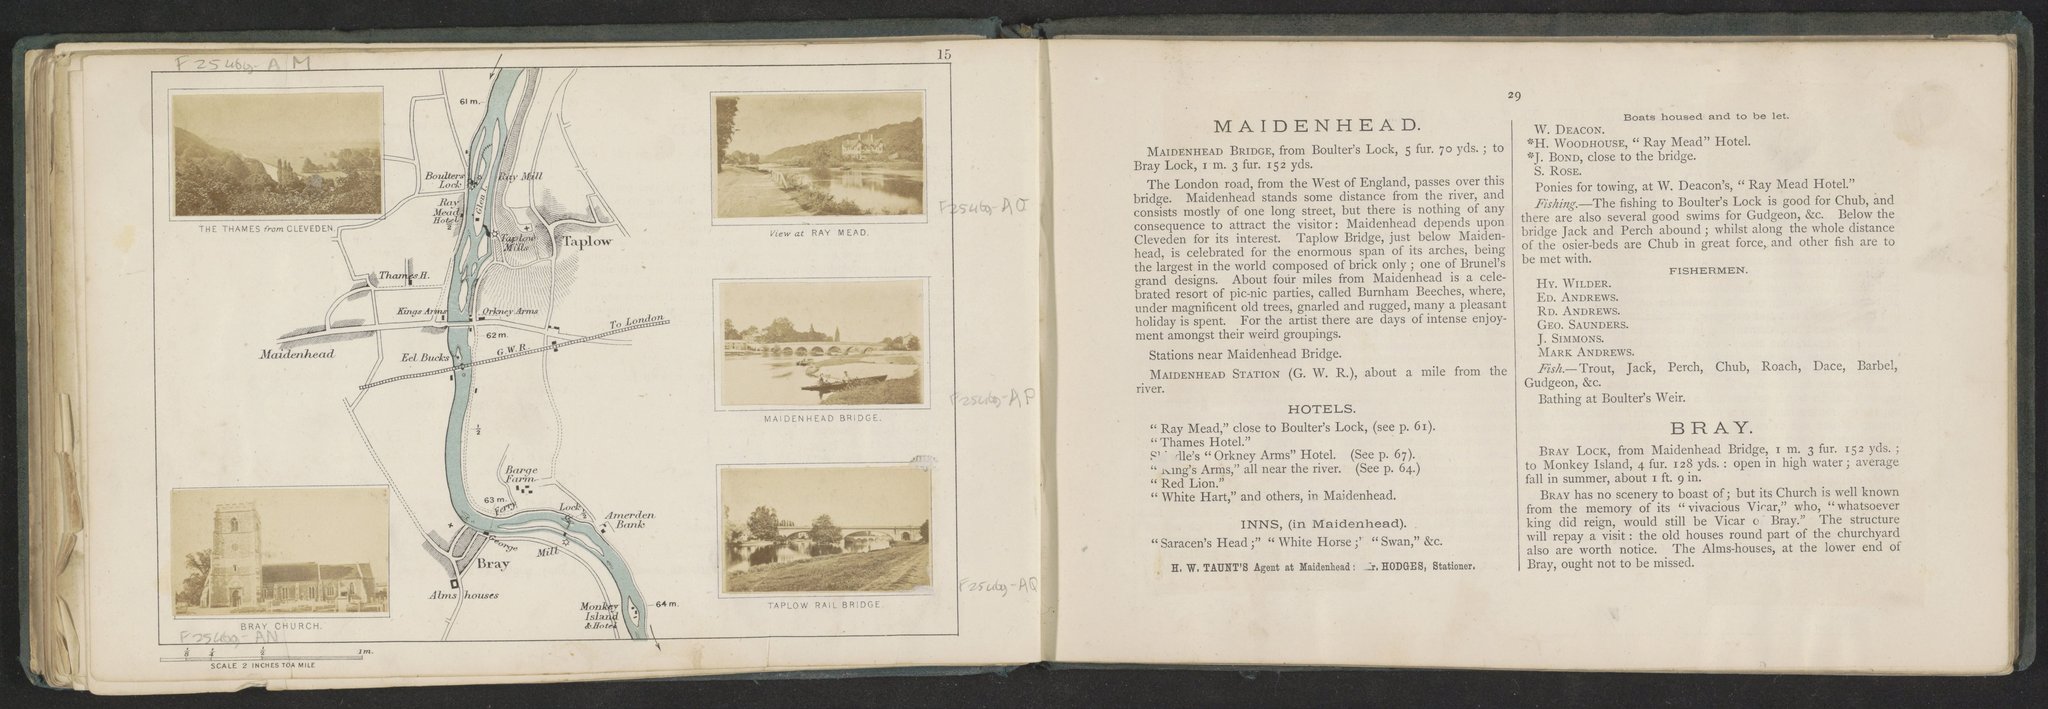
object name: photograph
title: Gezicht op de Theems bij Ray Mead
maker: henry w. taunt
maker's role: fotograaf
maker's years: 1842-1922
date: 1871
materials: photographic support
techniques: albumen print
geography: berkshire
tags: river, thames